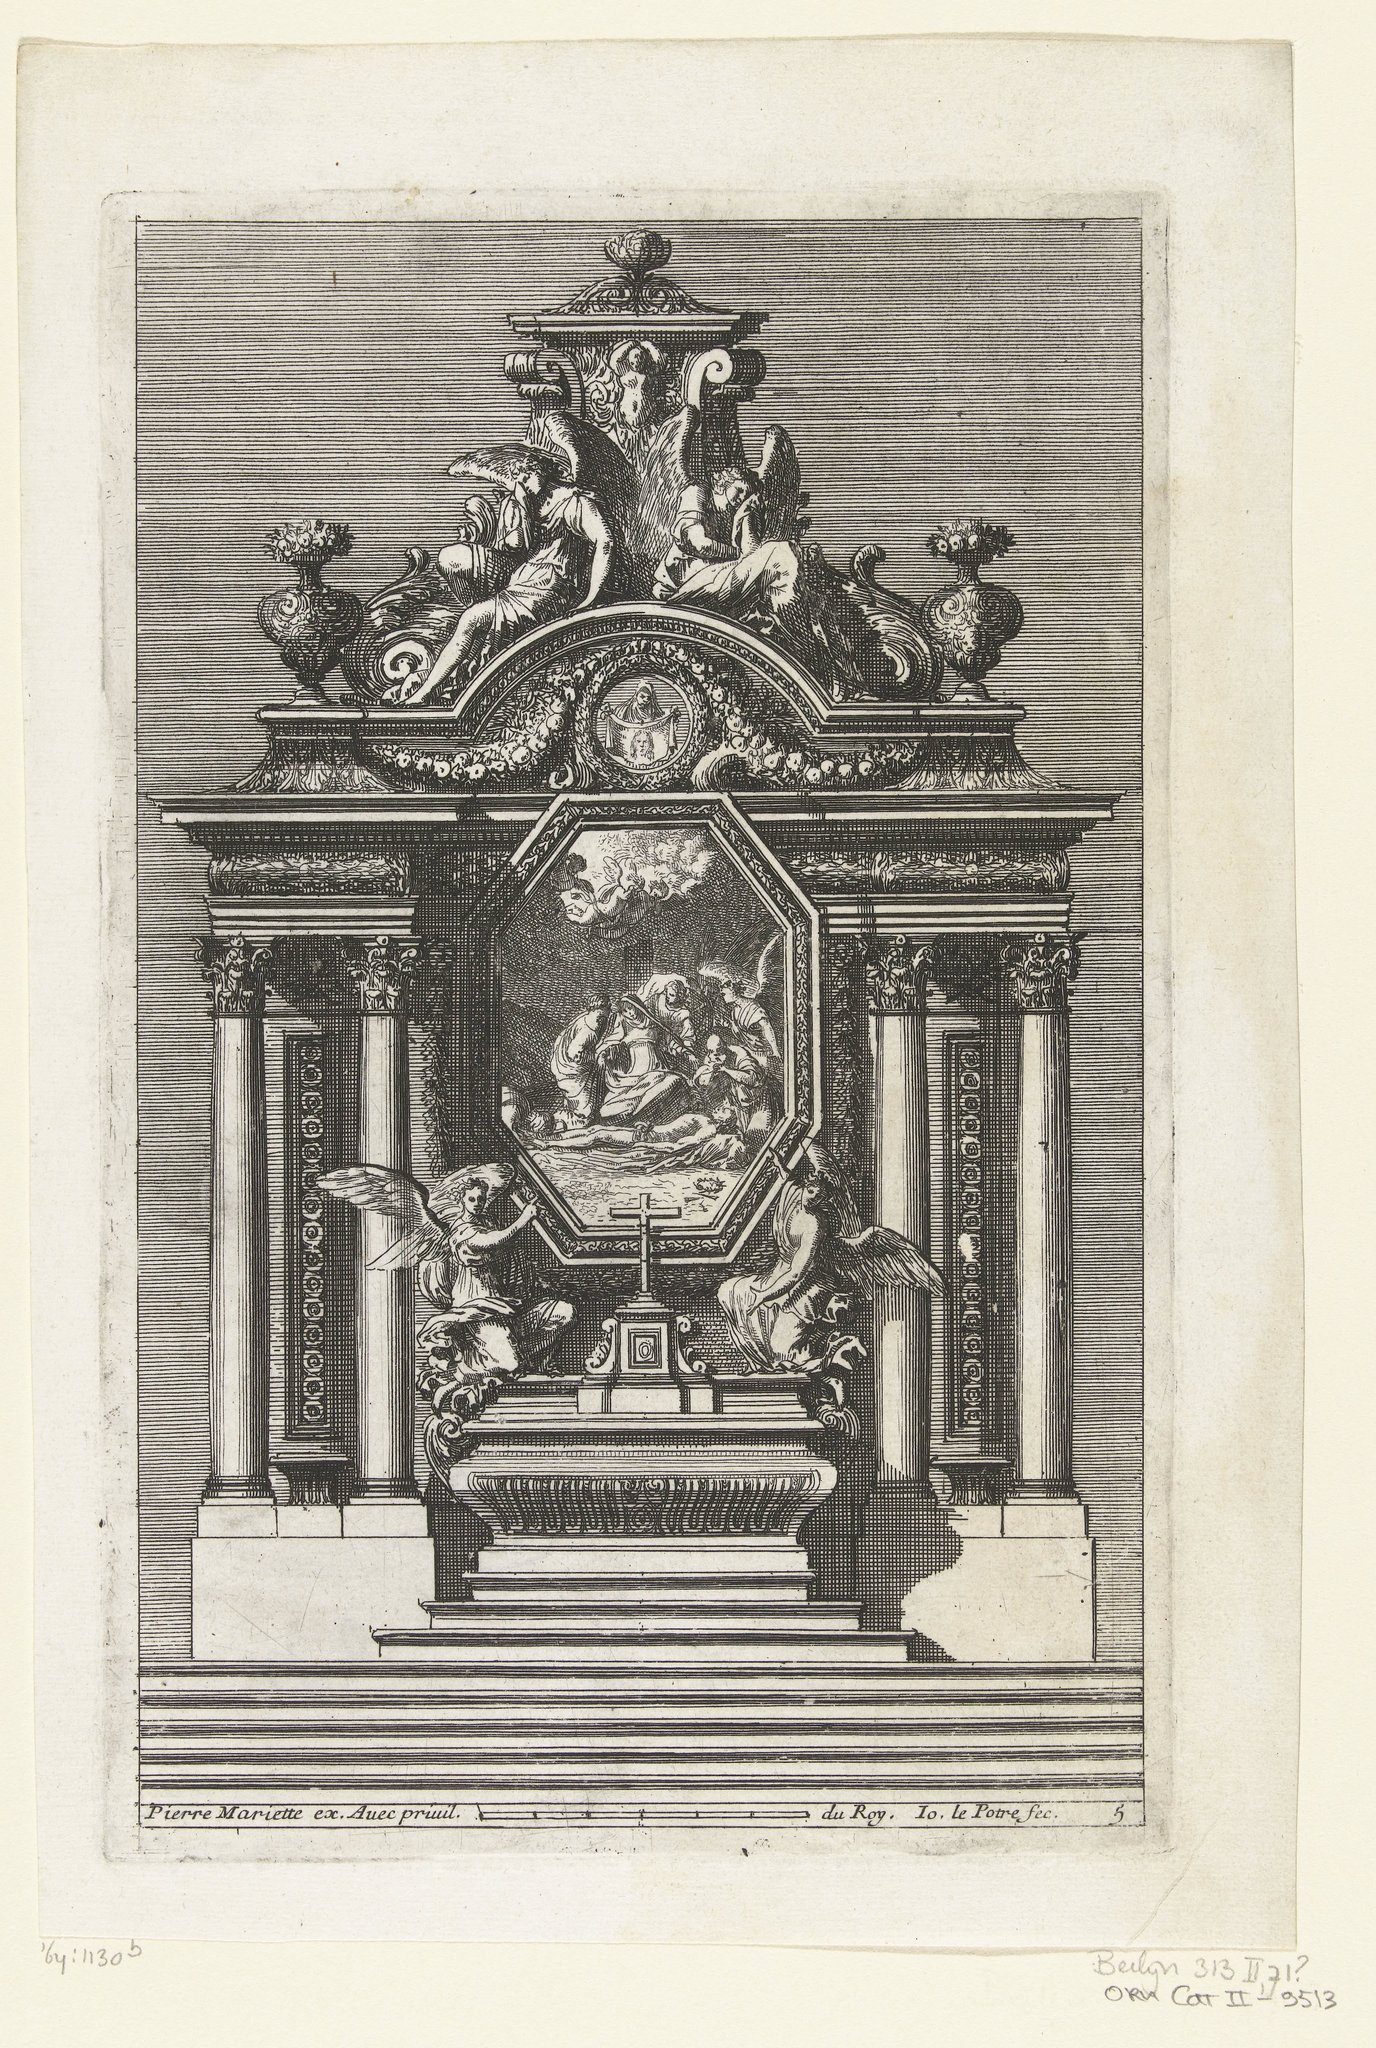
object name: print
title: Nouueaux Dessins d'Autels à la Romaine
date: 1658-1670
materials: paper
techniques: etching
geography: paris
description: In het midden hangt een achthoekig schilderij met de Bewening van Christus. Tweede afdruk.